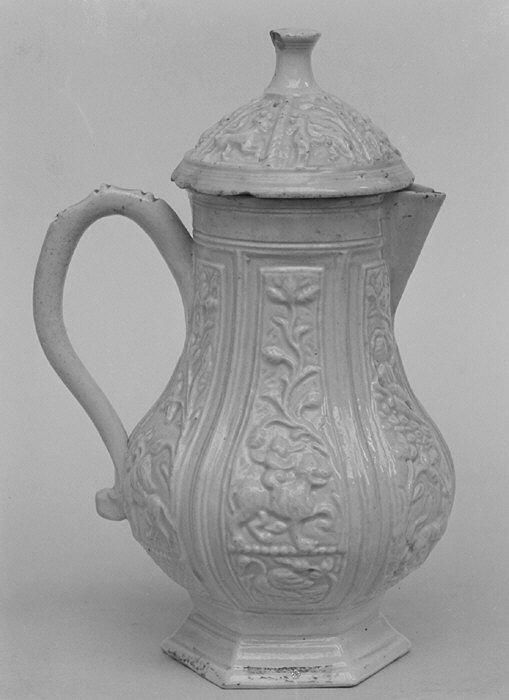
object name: milk jug with cover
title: Hot milk jug with cover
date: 1765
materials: stoneware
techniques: salt glaze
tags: human figures,animals